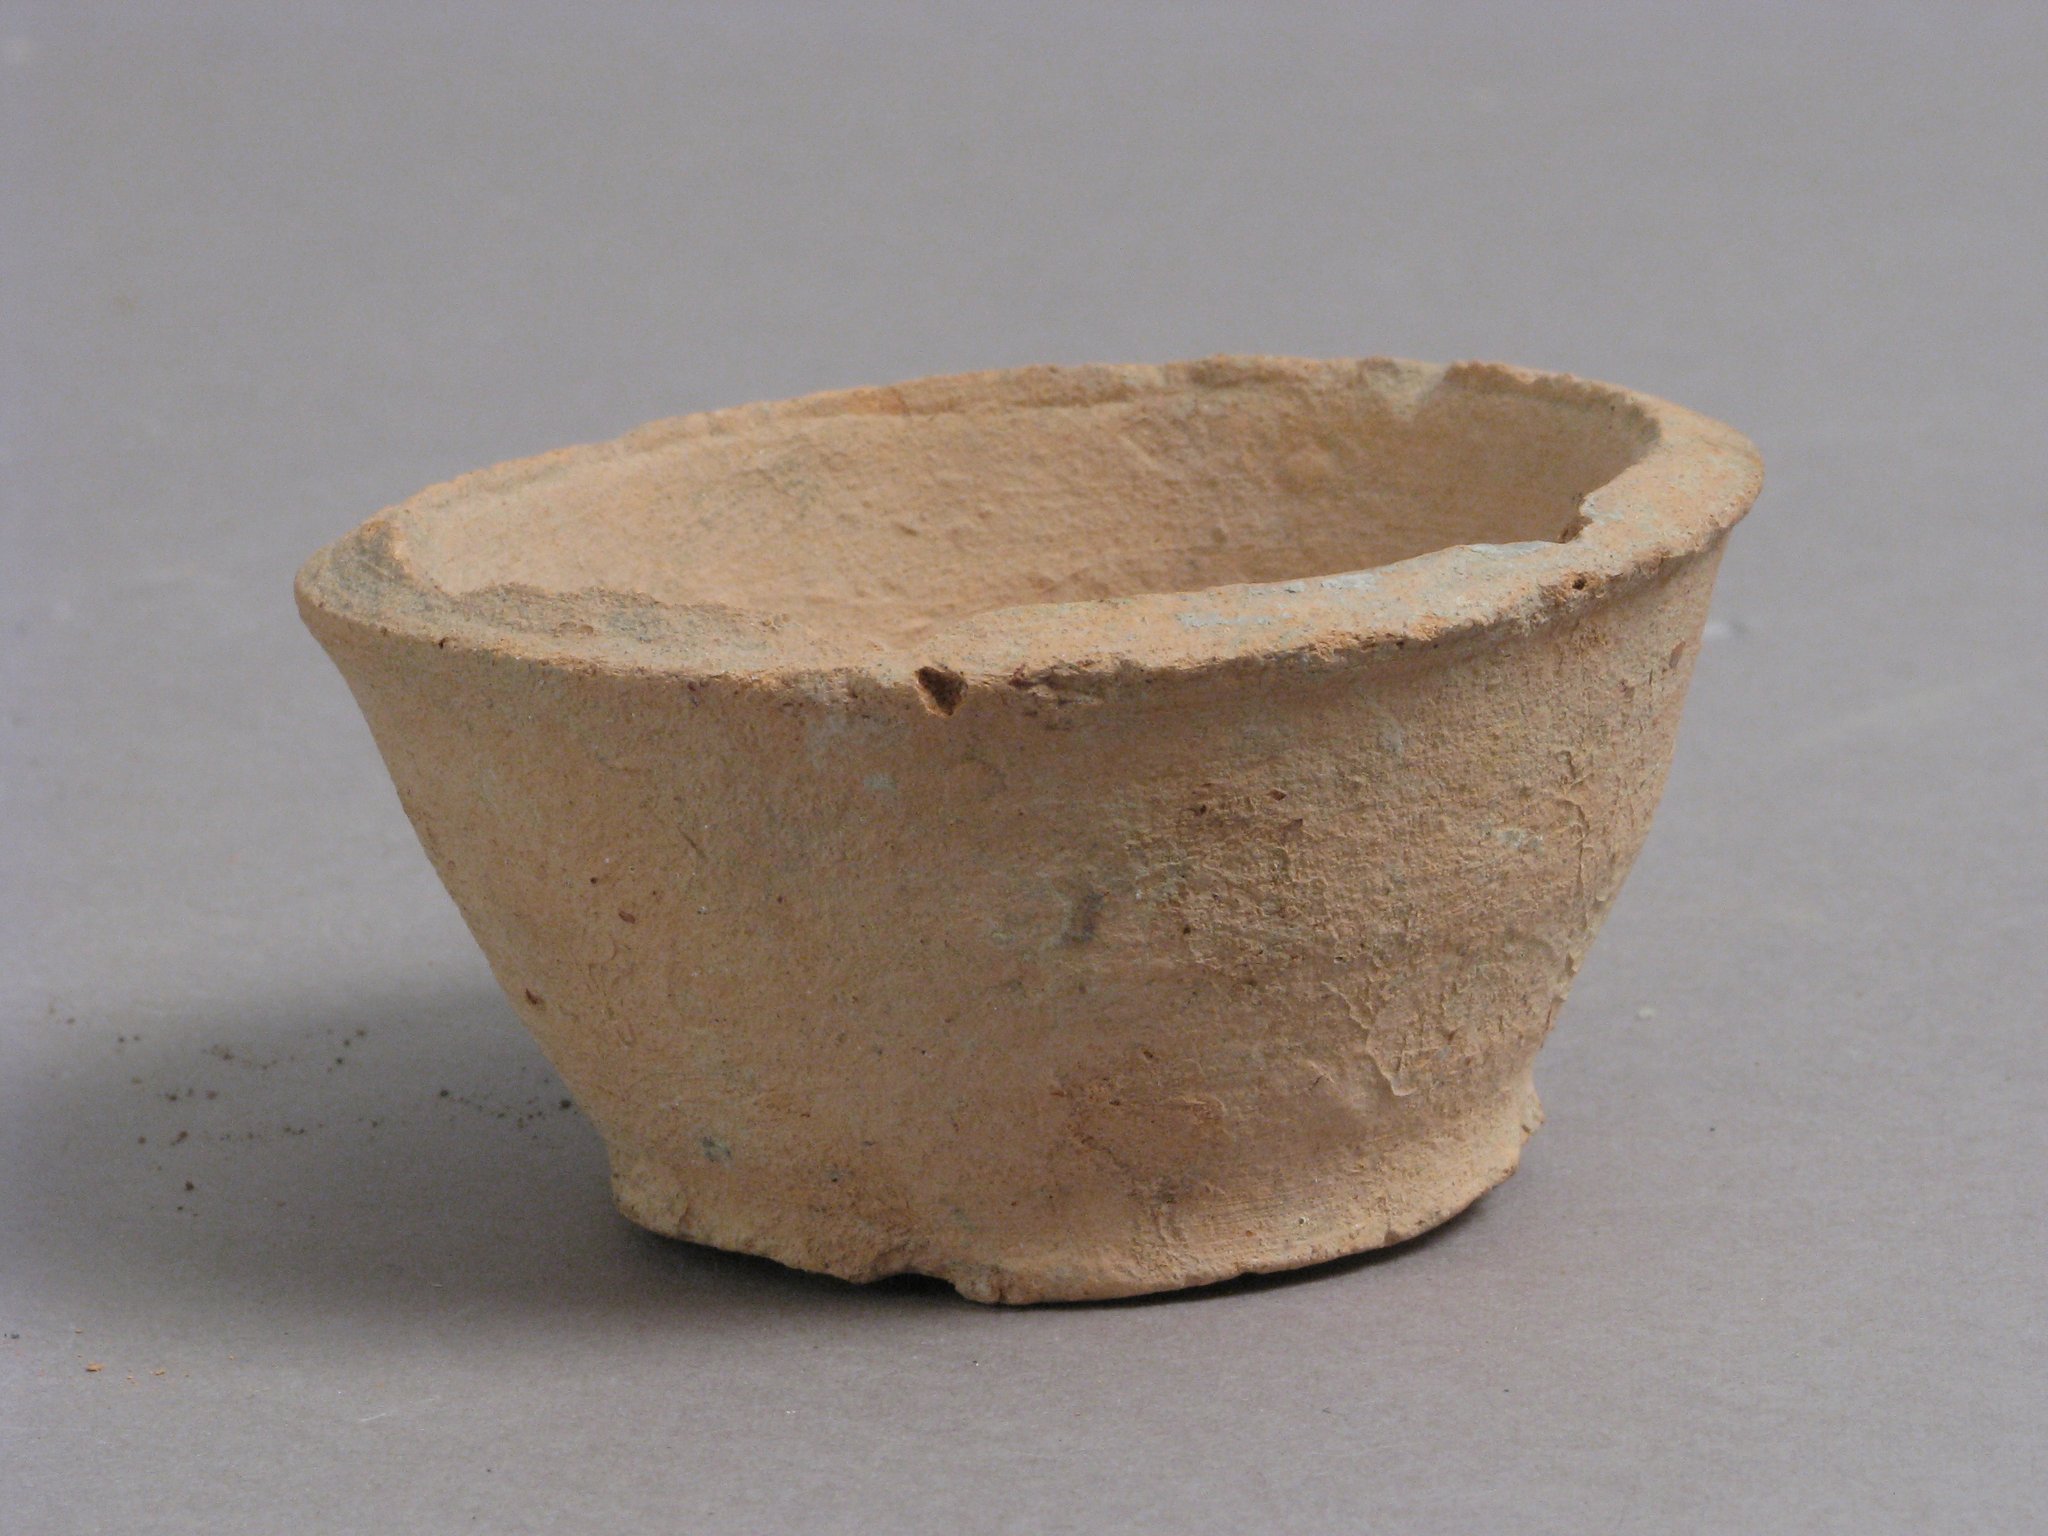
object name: bowl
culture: coptic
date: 301-700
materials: earthenware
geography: egypt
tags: bowls